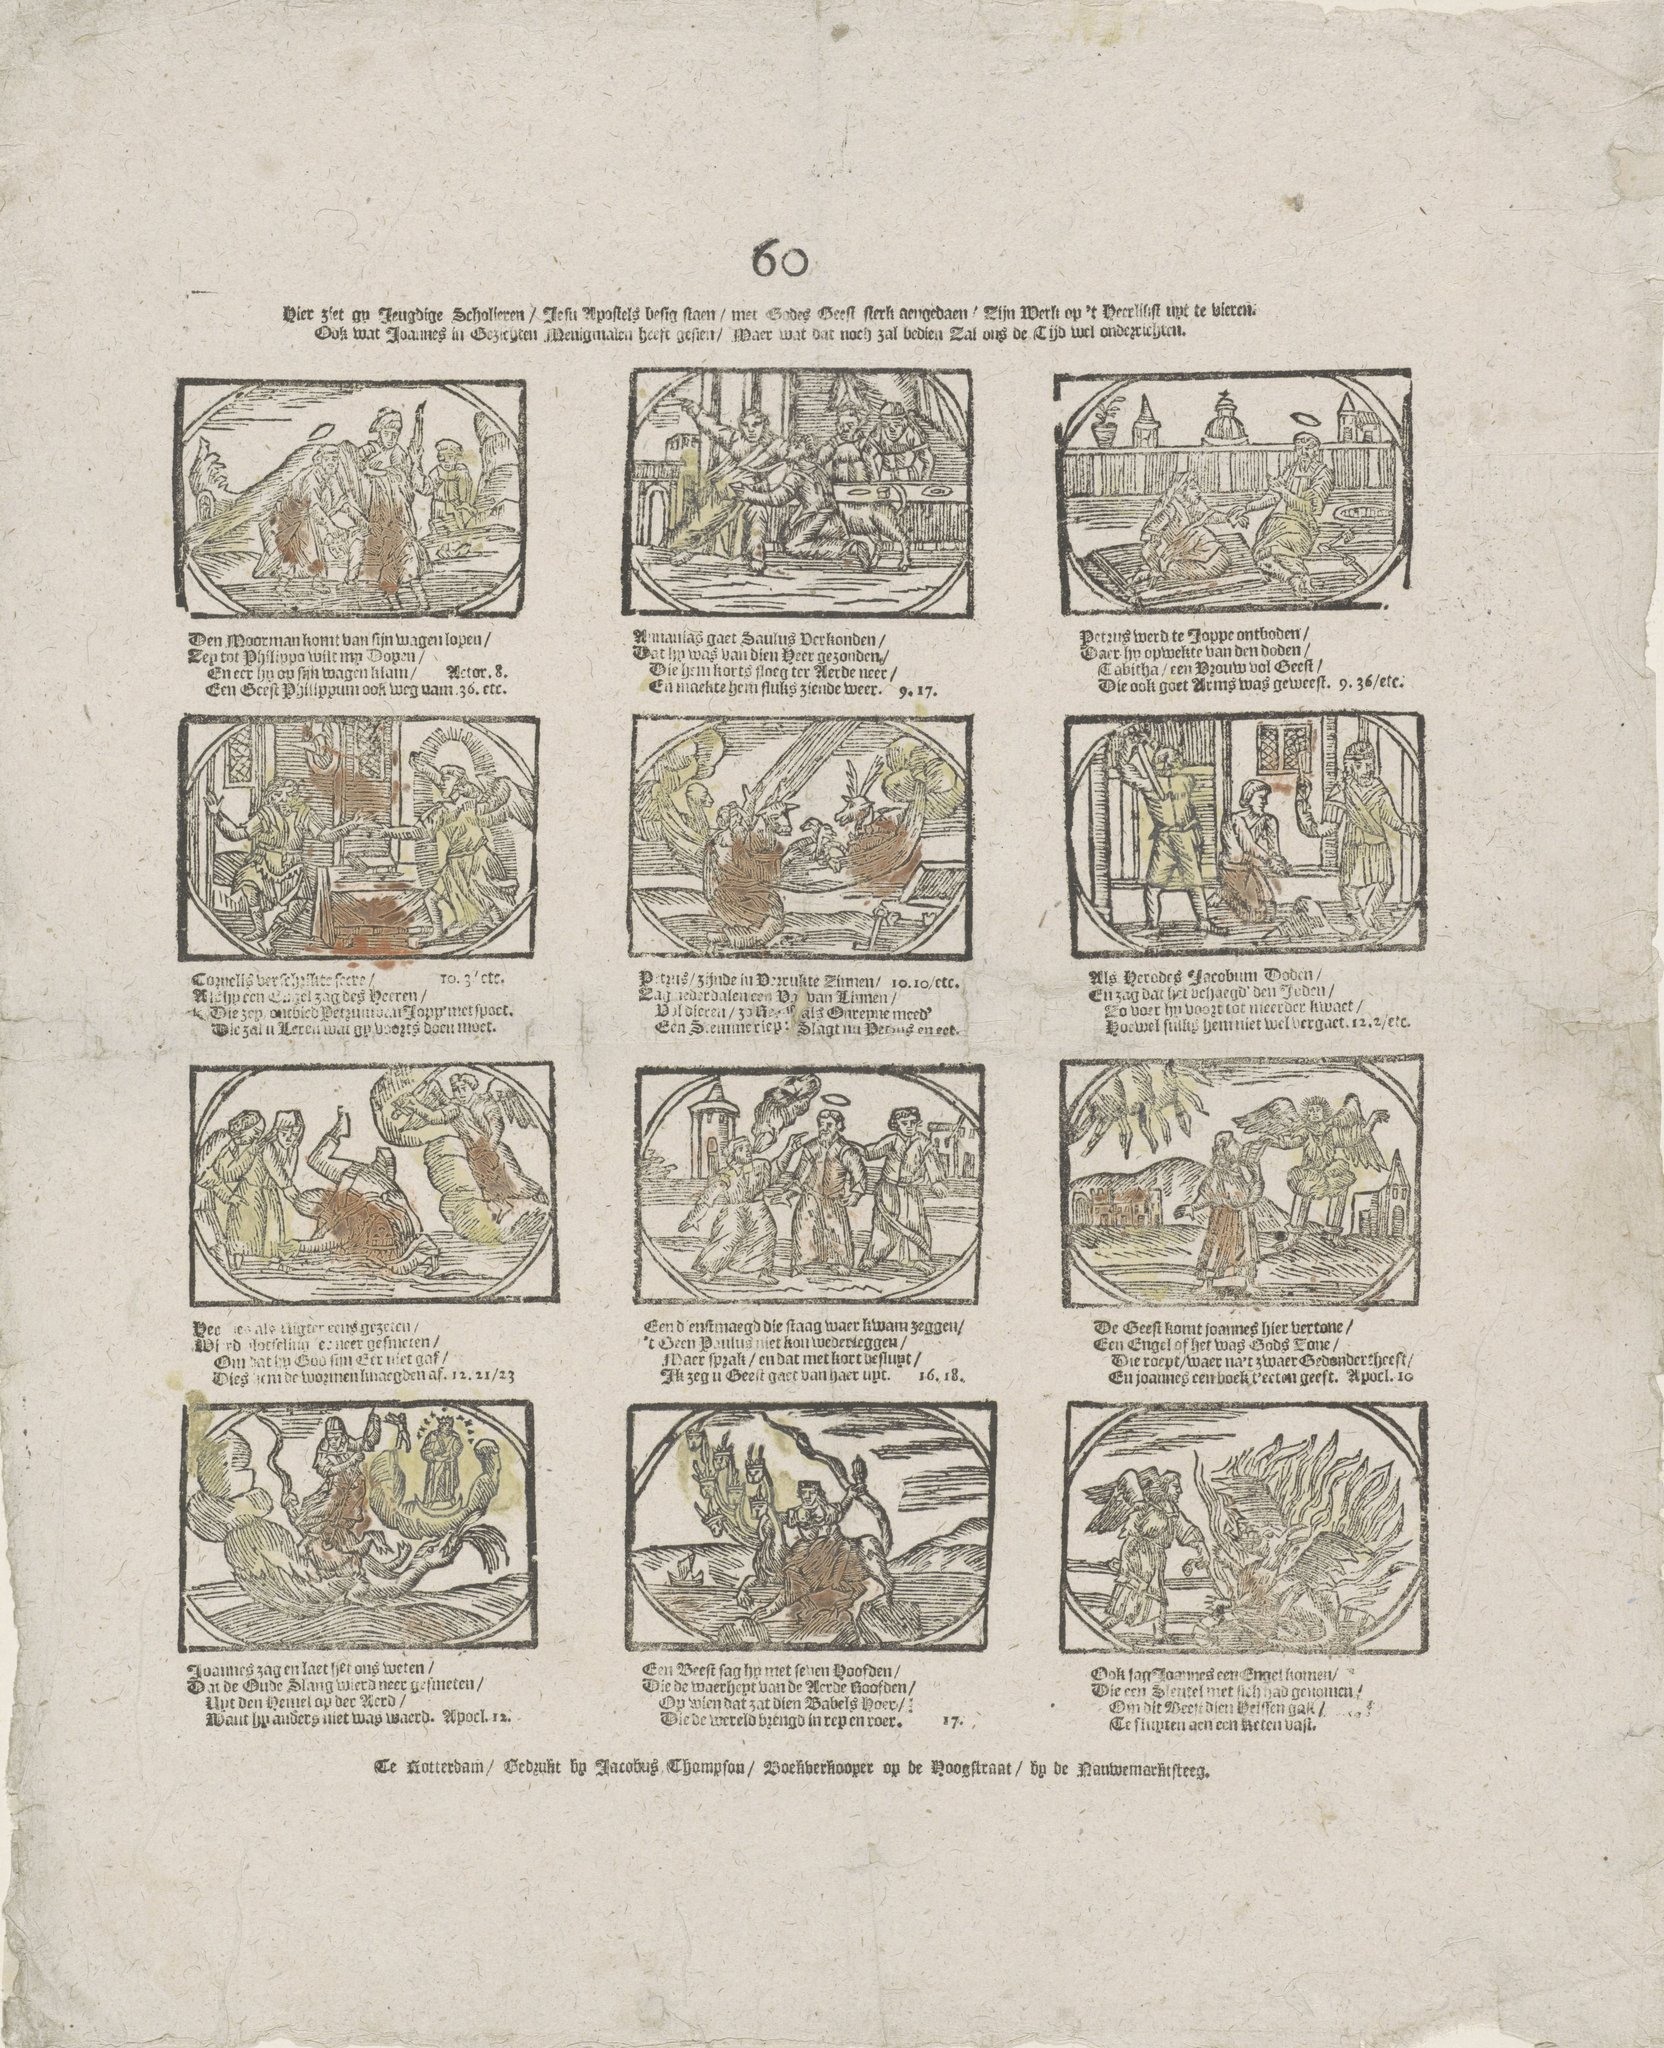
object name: popular print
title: Hier ziet gy heugdige scholieren / Jesu Apostels besig staen (...)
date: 1791-1812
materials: paper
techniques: colour, letterpress printing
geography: netherlands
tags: the revelation of john, the apocalypse, new testament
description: Blad met 12 voorstellingen van verhalen uit het Nieuwe Testament, waaronder voorstellingen over de Apocalyps. Onder elke afbeelding een vierregelig vers. Genummerd midden boven: No. 60.